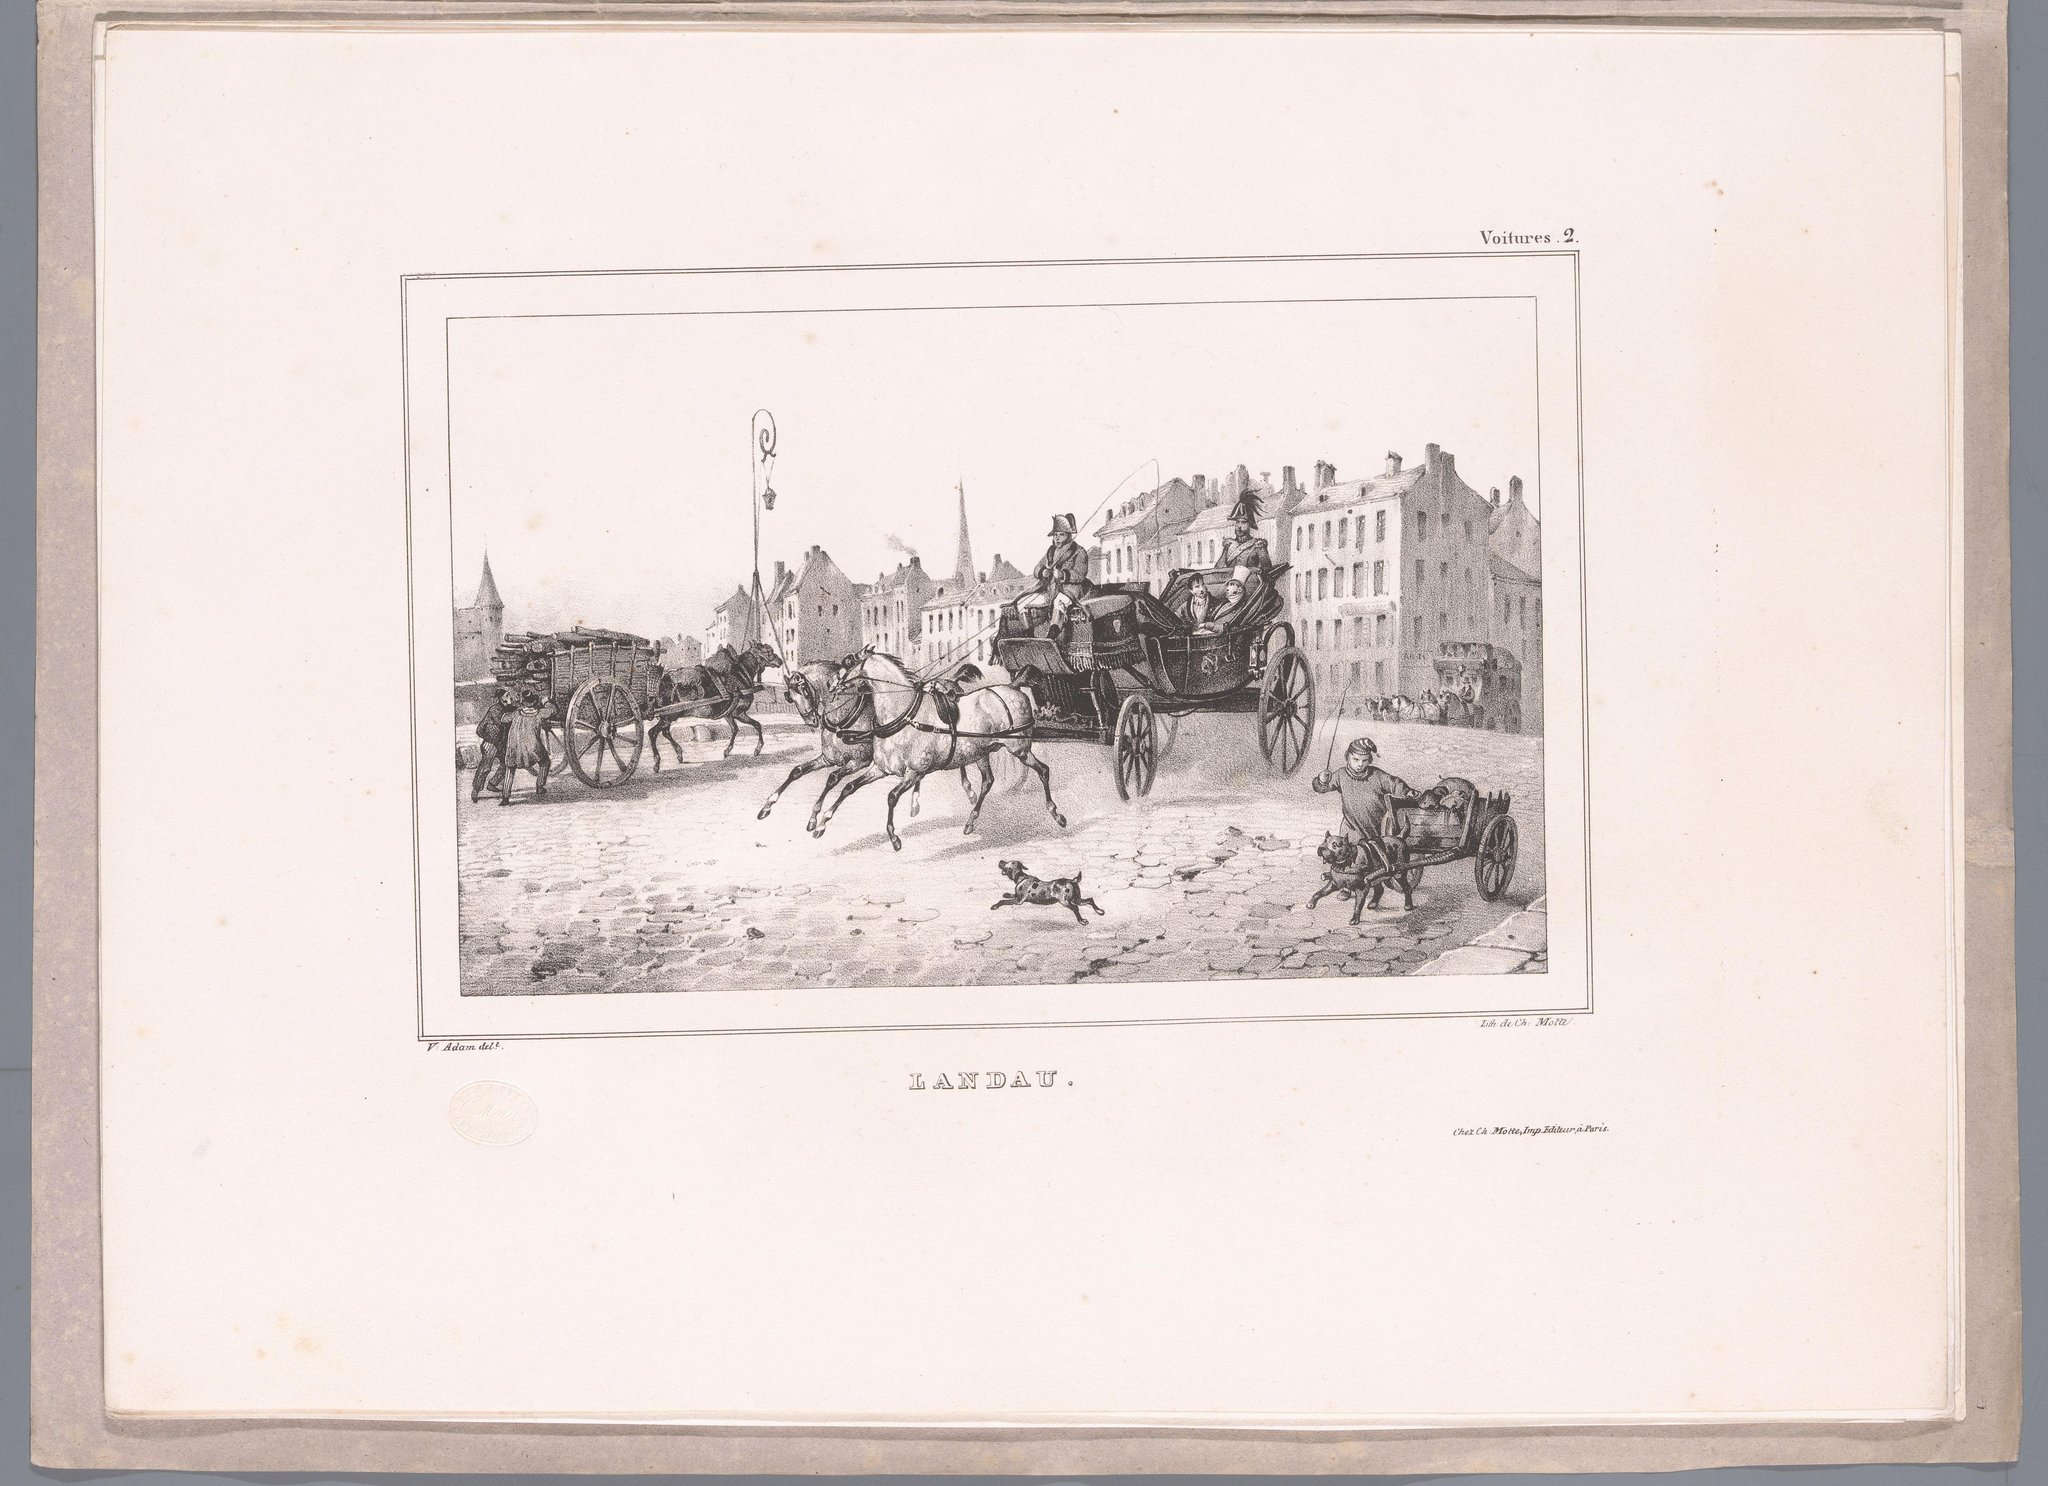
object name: print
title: Twee passagiers worden voortgereden in een Landauer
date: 1827-1828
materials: paper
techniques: lithography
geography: paris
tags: four-wheeled, animal-drawn vehicle, e.g.: cab, carriage, coach, passenger carriage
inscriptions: stamp: Lugt 1828b, collector's mark: Lugt 2228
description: De prentserie waar deze prent deel van uitmaakt werd in drie delen van twaalf prenten vanaf 1827 tot en met 1830 gepubliceerd. Elk van de drie delen werd voorzien van een aparte omslag. De landauer was een vierwielig rijtuig met twee bankjes tegenover elkaar en een kap die in twee helften open- en dichtgeklapt kon worden.